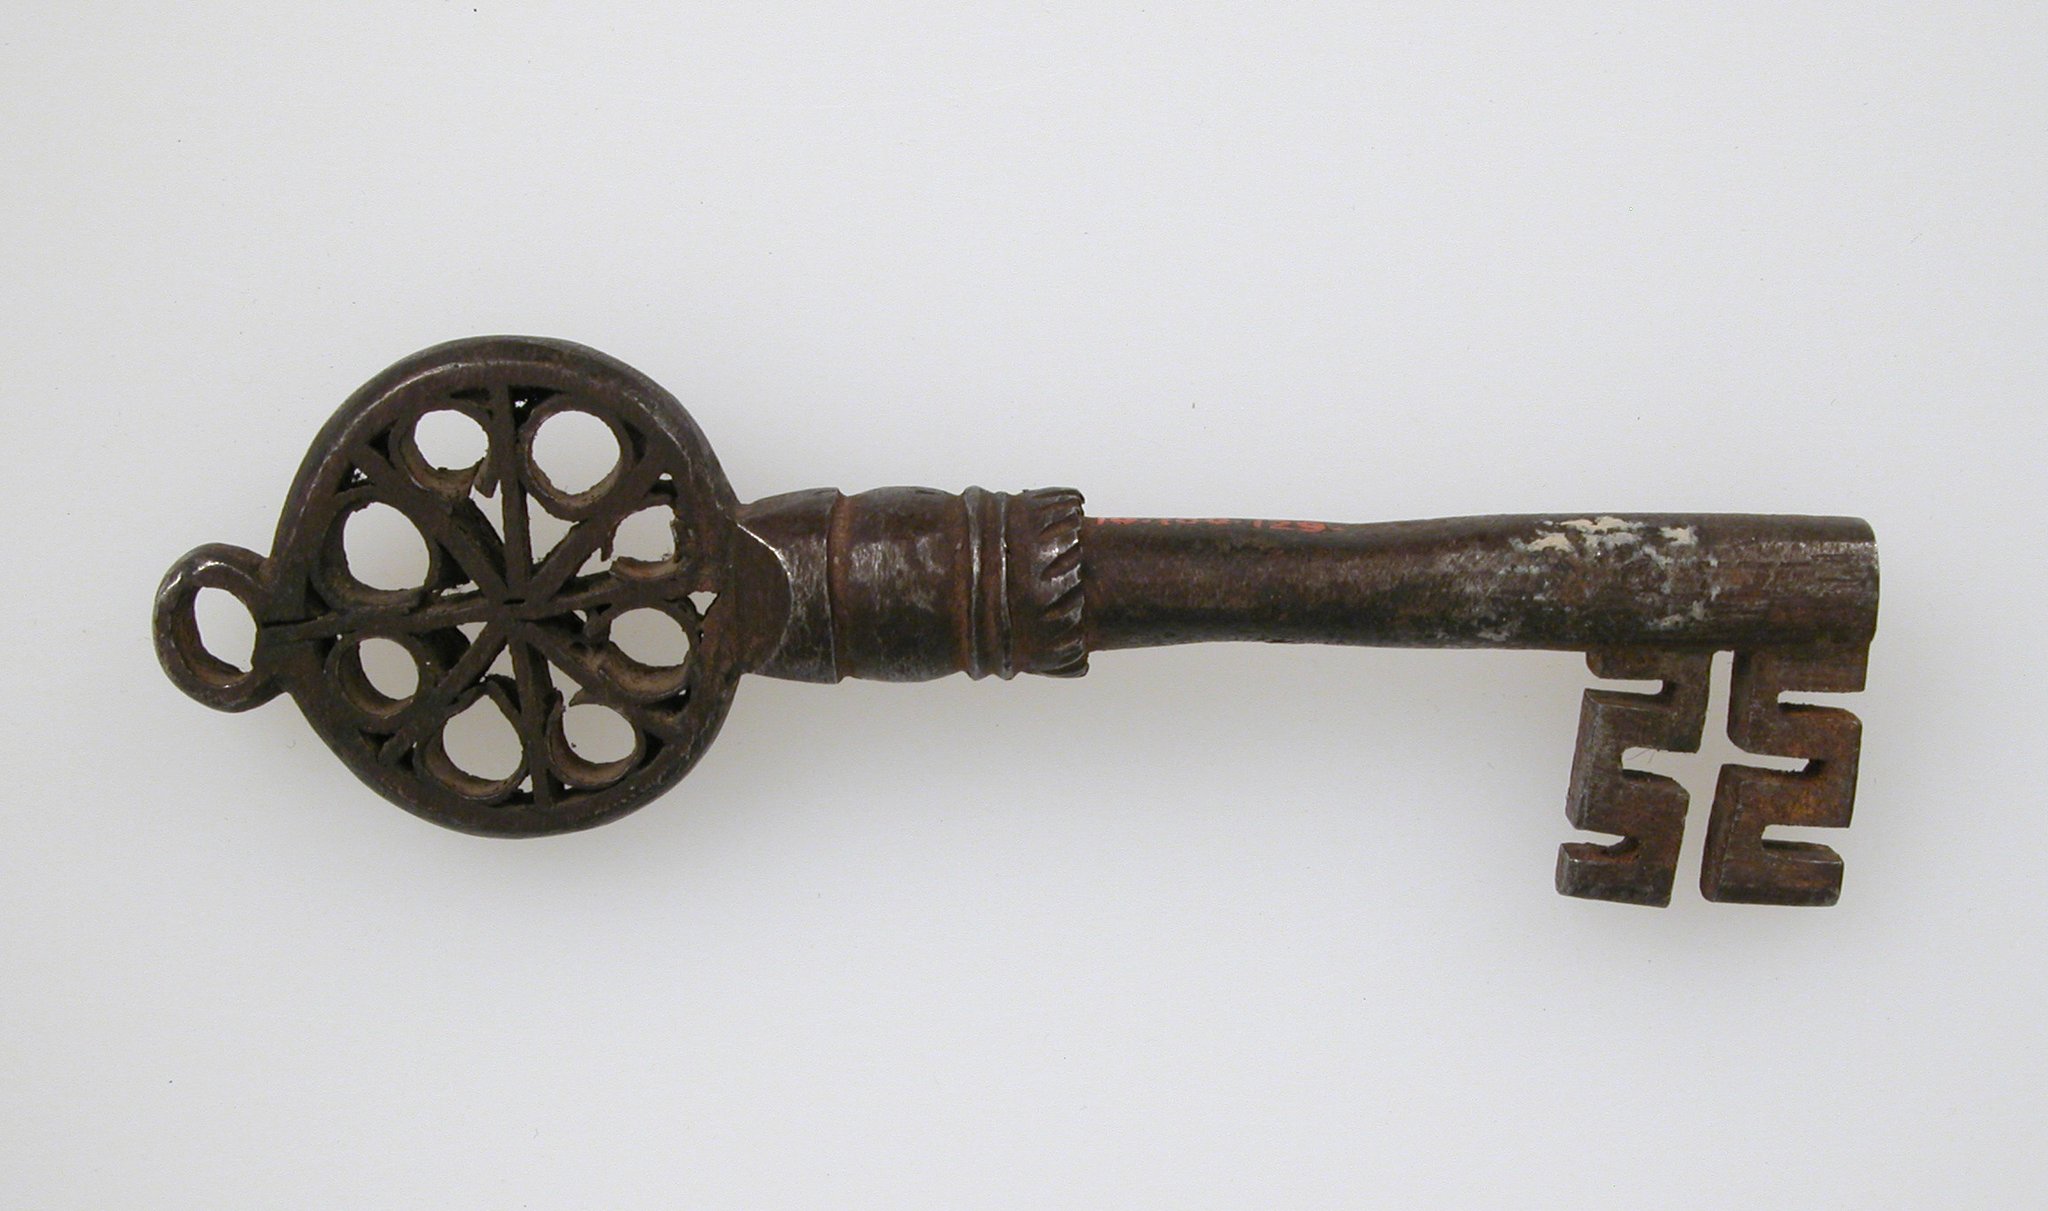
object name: key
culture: german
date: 1401-1500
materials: iron